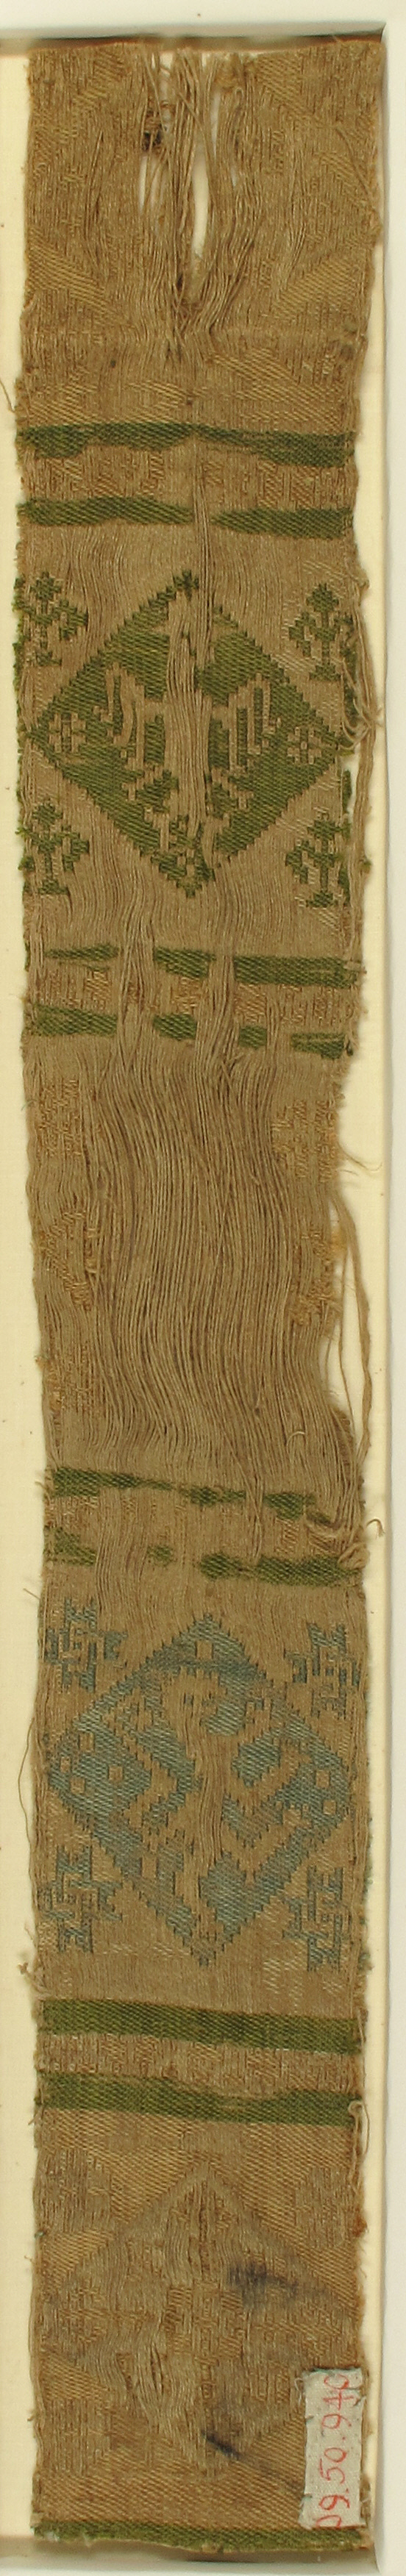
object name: textile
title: Textile with Silk and Linen Weave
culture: spanish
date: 1301-1400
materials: linen, silk